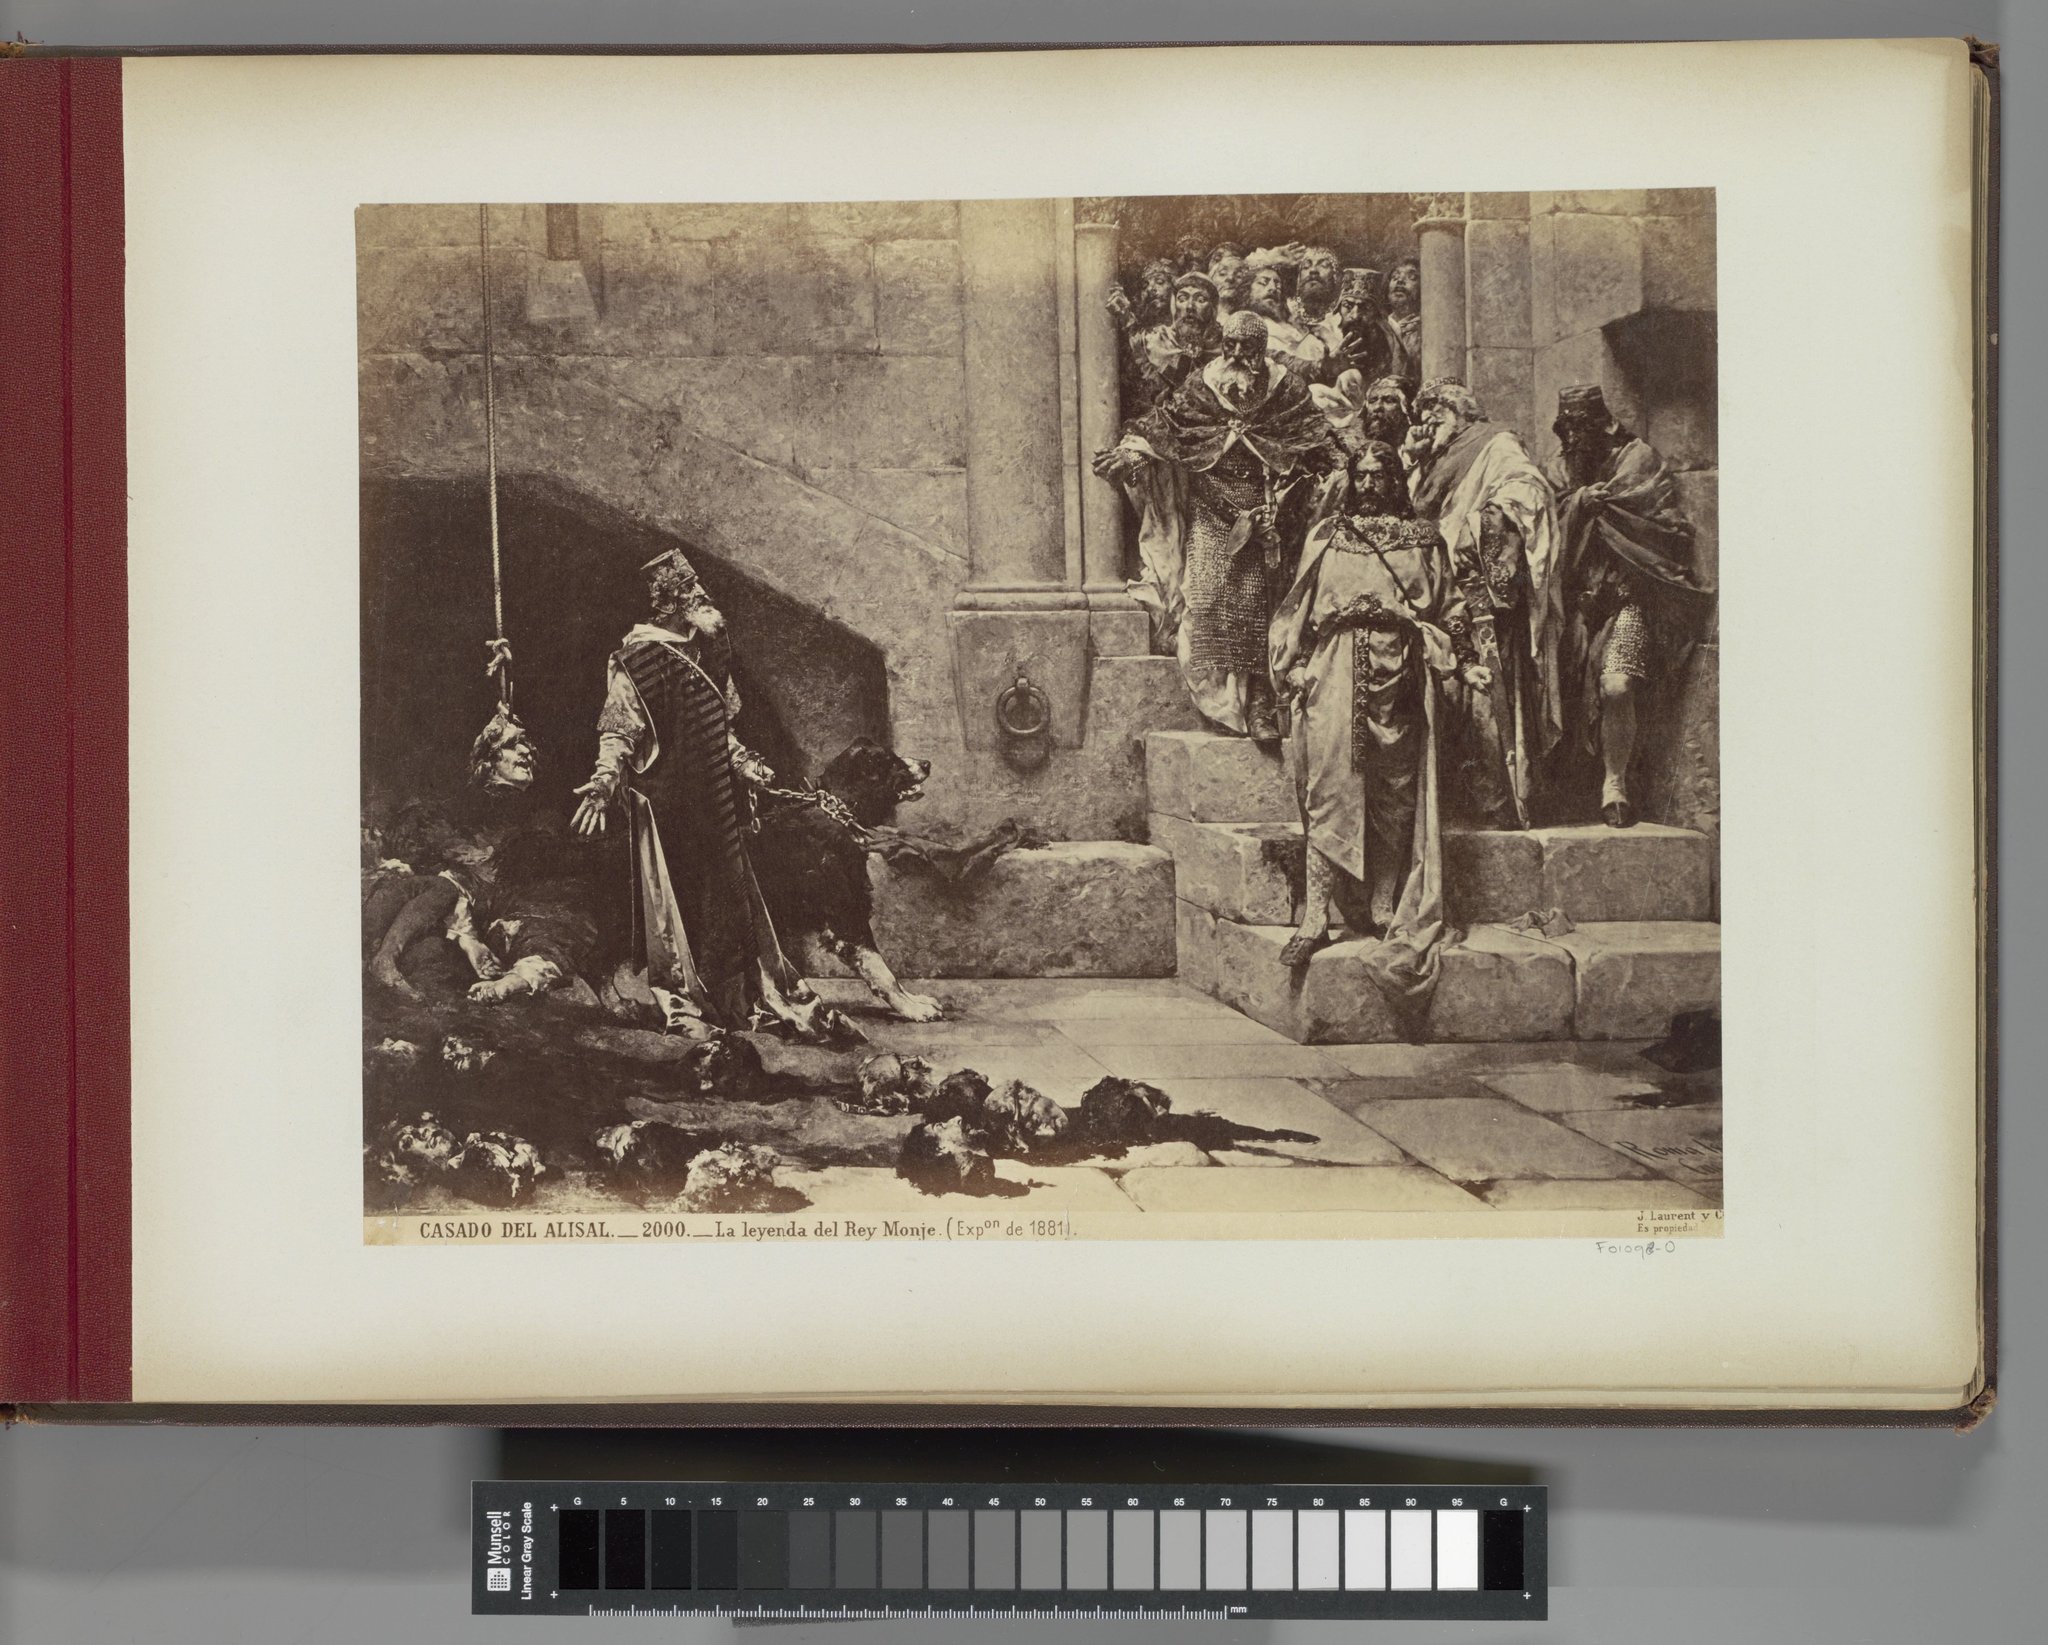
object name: photograph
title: CASADO DEL ALISAL.- La leyenda del Rey Monje. (Expon de 1881).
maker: juan laurent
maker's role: publisher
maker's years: 1816-1896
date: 1881-1885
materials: cardboard, paper, photographic support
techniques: albumen print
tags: murder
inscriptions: negative number: ‘2000’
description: Onderdeel van Reisalbum met foto's van bezienswaardigheden in Spanje en Marokko.